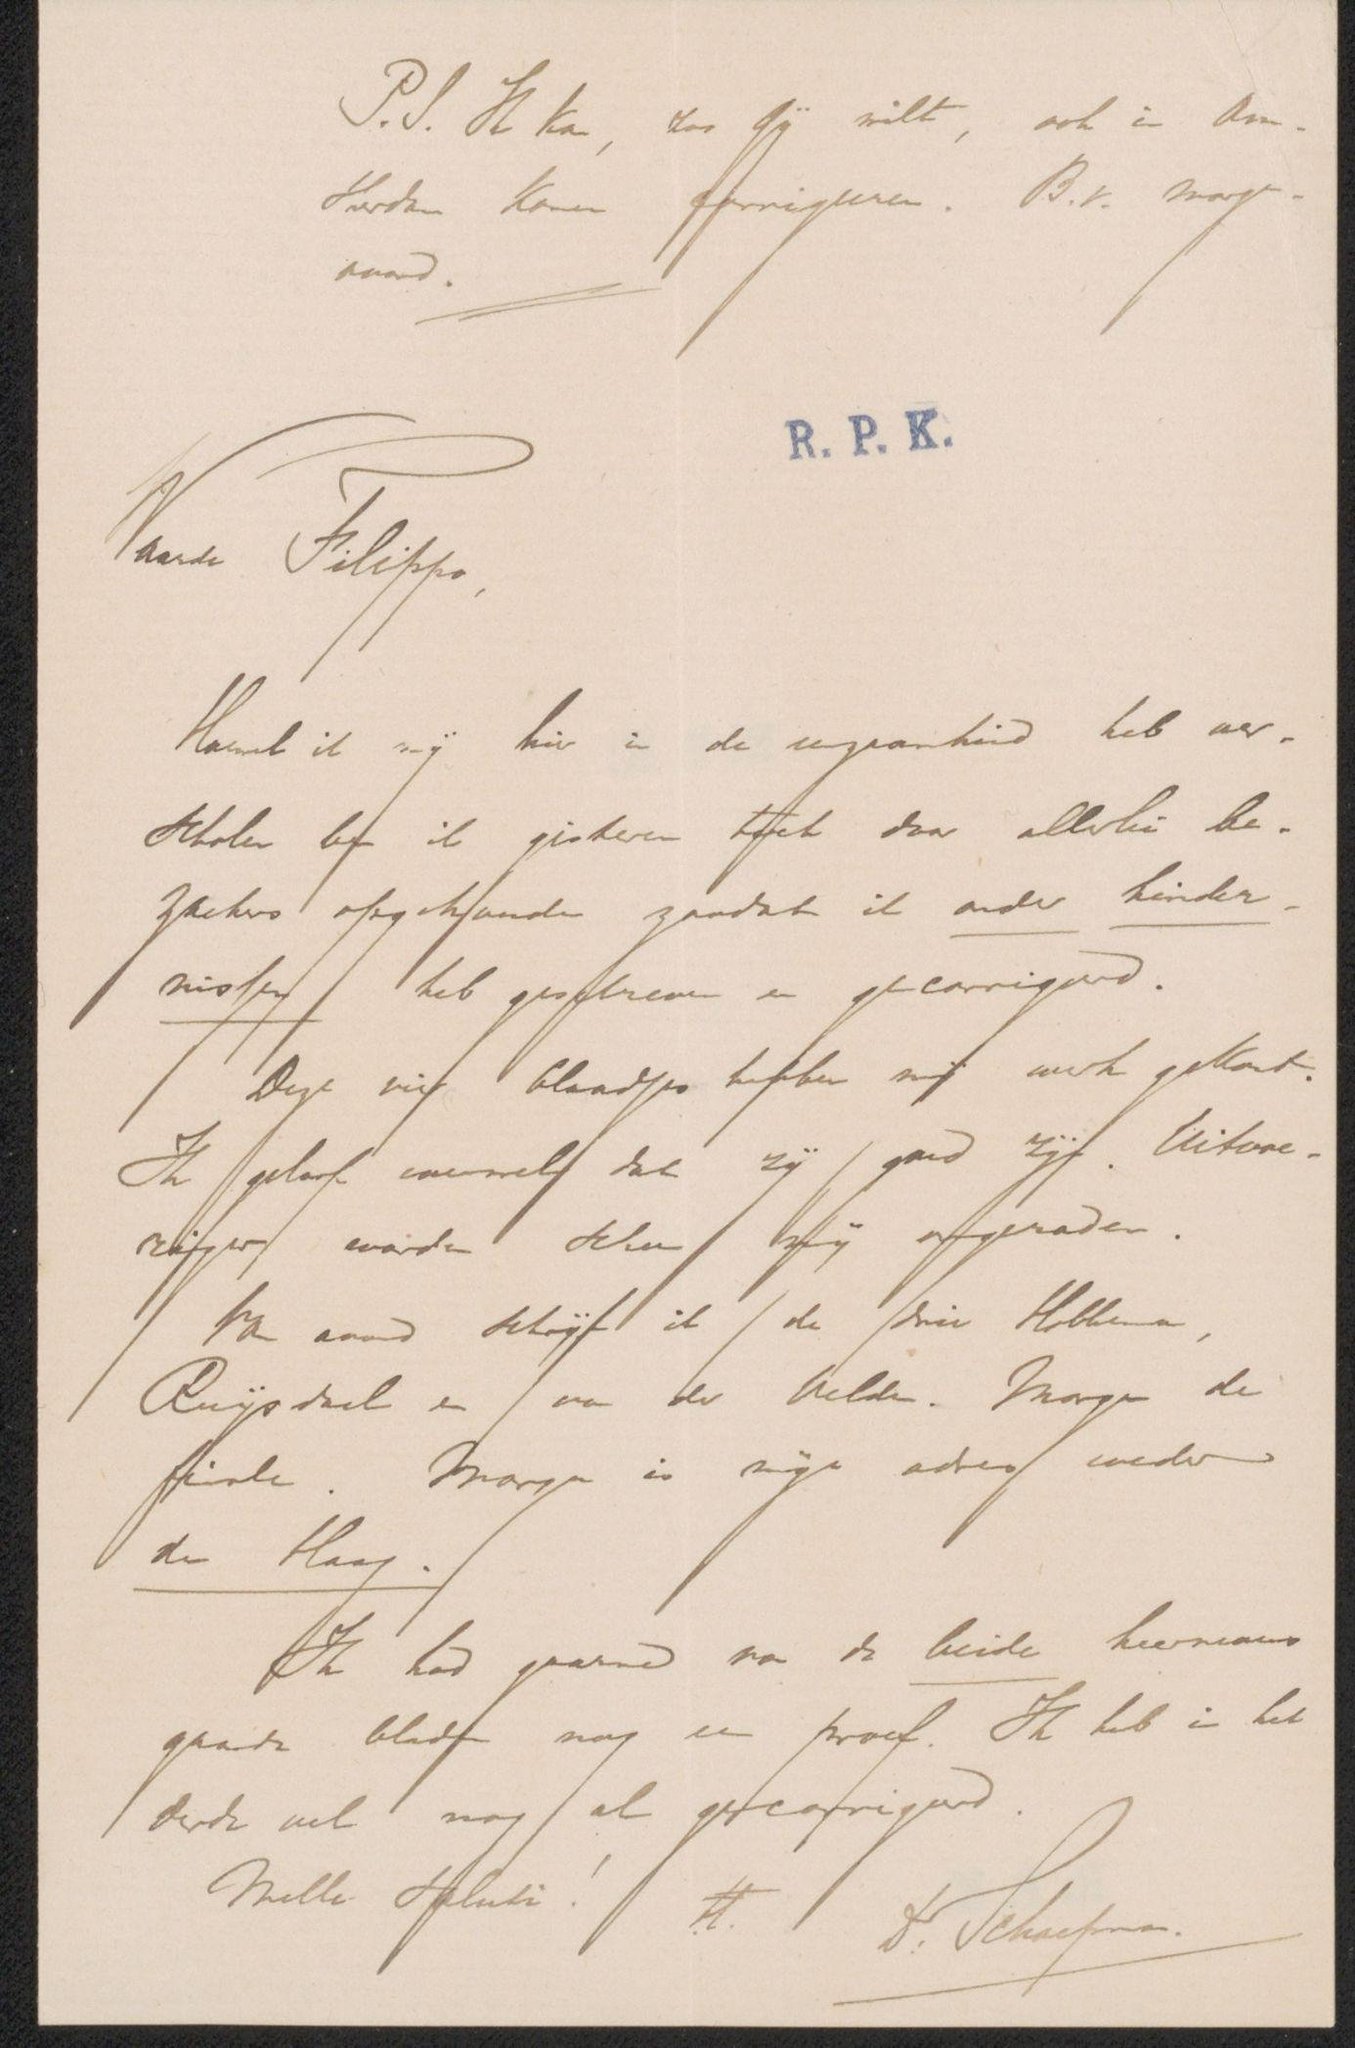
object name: letter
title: Brief aan Filippo Tessaro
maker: herman johannes aloysius maria schaepman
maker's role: priest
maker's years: 1844-1903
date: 1854-1903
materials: ink, paper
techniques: pen, writing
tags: meindert hobbema, haarlem, amsterdam, painter, print maker, draughtsman, jacob isaacksz van ruisdael, printed matter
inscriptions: collector's mark: Lugt 2233